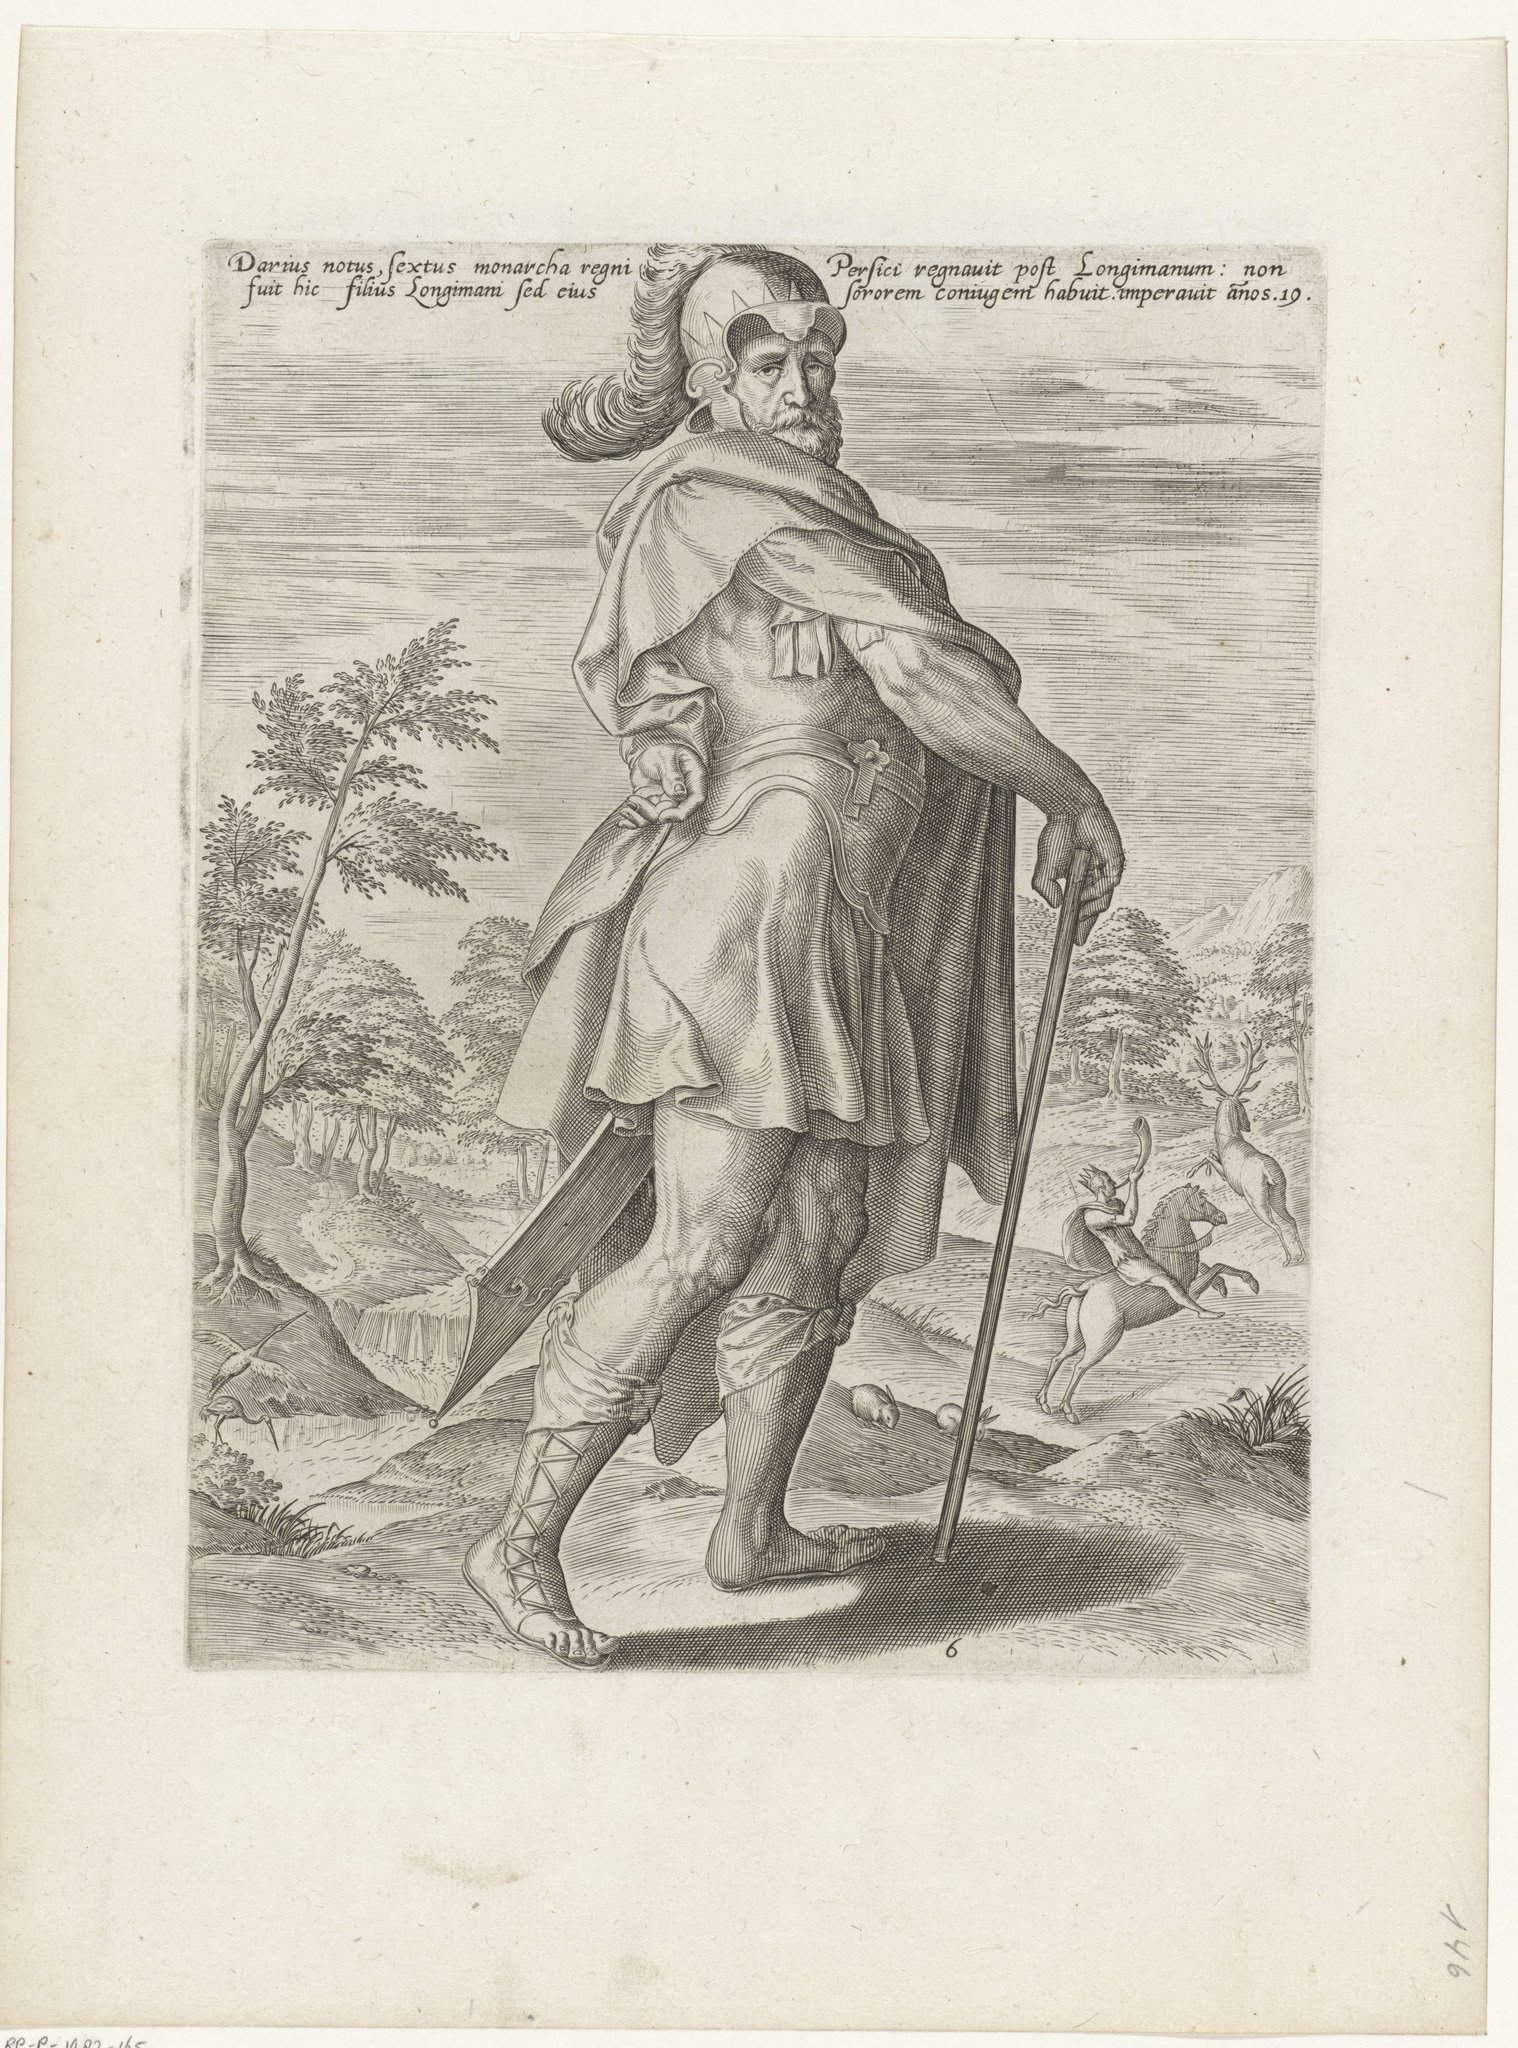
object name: print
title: Koning Darius II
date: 1585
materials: paper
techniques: engraving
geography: antwerp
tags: game, hunted animals, hunting horn, male persons from classical history, ruler, sovereign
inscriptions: collector's mark: Lugt 2760, collector's mark: Lugt 2228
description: De eerdere staat van deze prent is verschenen in de serie met de titel: Series Regum Persarum (...).. Prent gebruikt in: Thesaurus sacrarum historiaru[m] veteris (et novi) testame[n]ti, elega[n]tissimis imaginibus expressu[m] excelle[n]tissimoru[m] in hac arte viroru[m] opera : nu[n]c primu[m] in luce[m] editus. Antwerpen: Gerard de Jode, 1585.